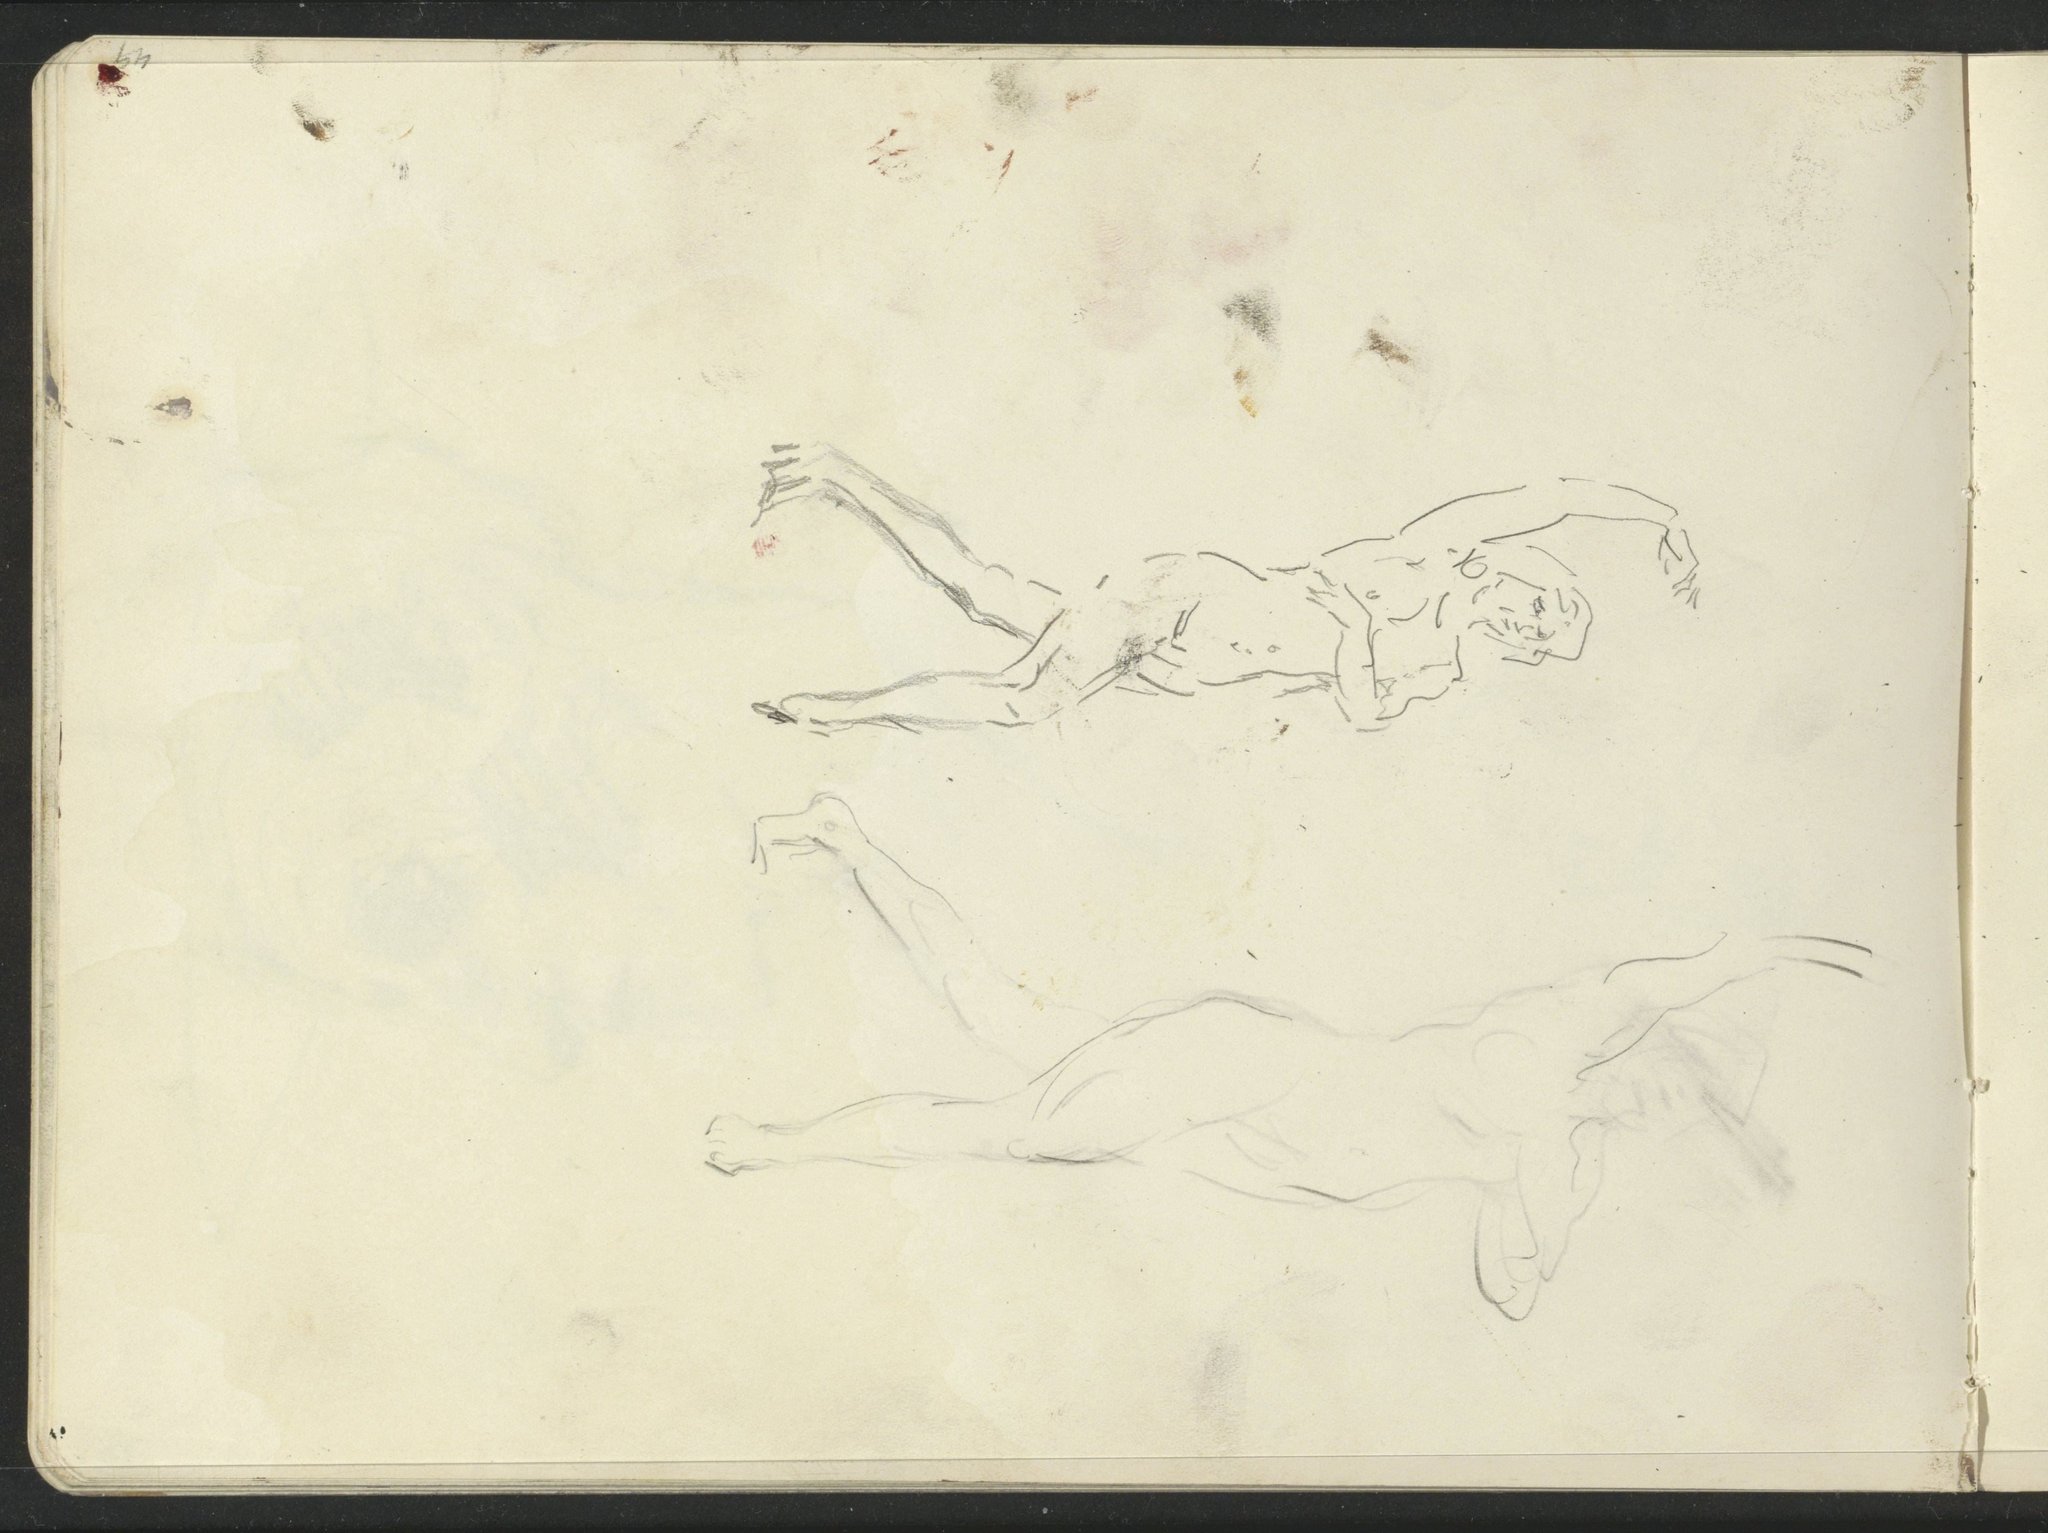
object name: sketchbook leaf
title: Twee studies van vrouwelijk naakt, mogelijk dansend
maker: isaac israels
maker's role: draughtsman, painter, print maker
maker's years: 1865-1934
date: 1915-1934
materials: paper, pencil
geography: the hague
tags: the (nude) human figure; 'corpo humano' (ripa) - aa - female human figure (+ standing), female dancer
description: Blad 22 verso uit schetsboek XVIII met 35 bladen.